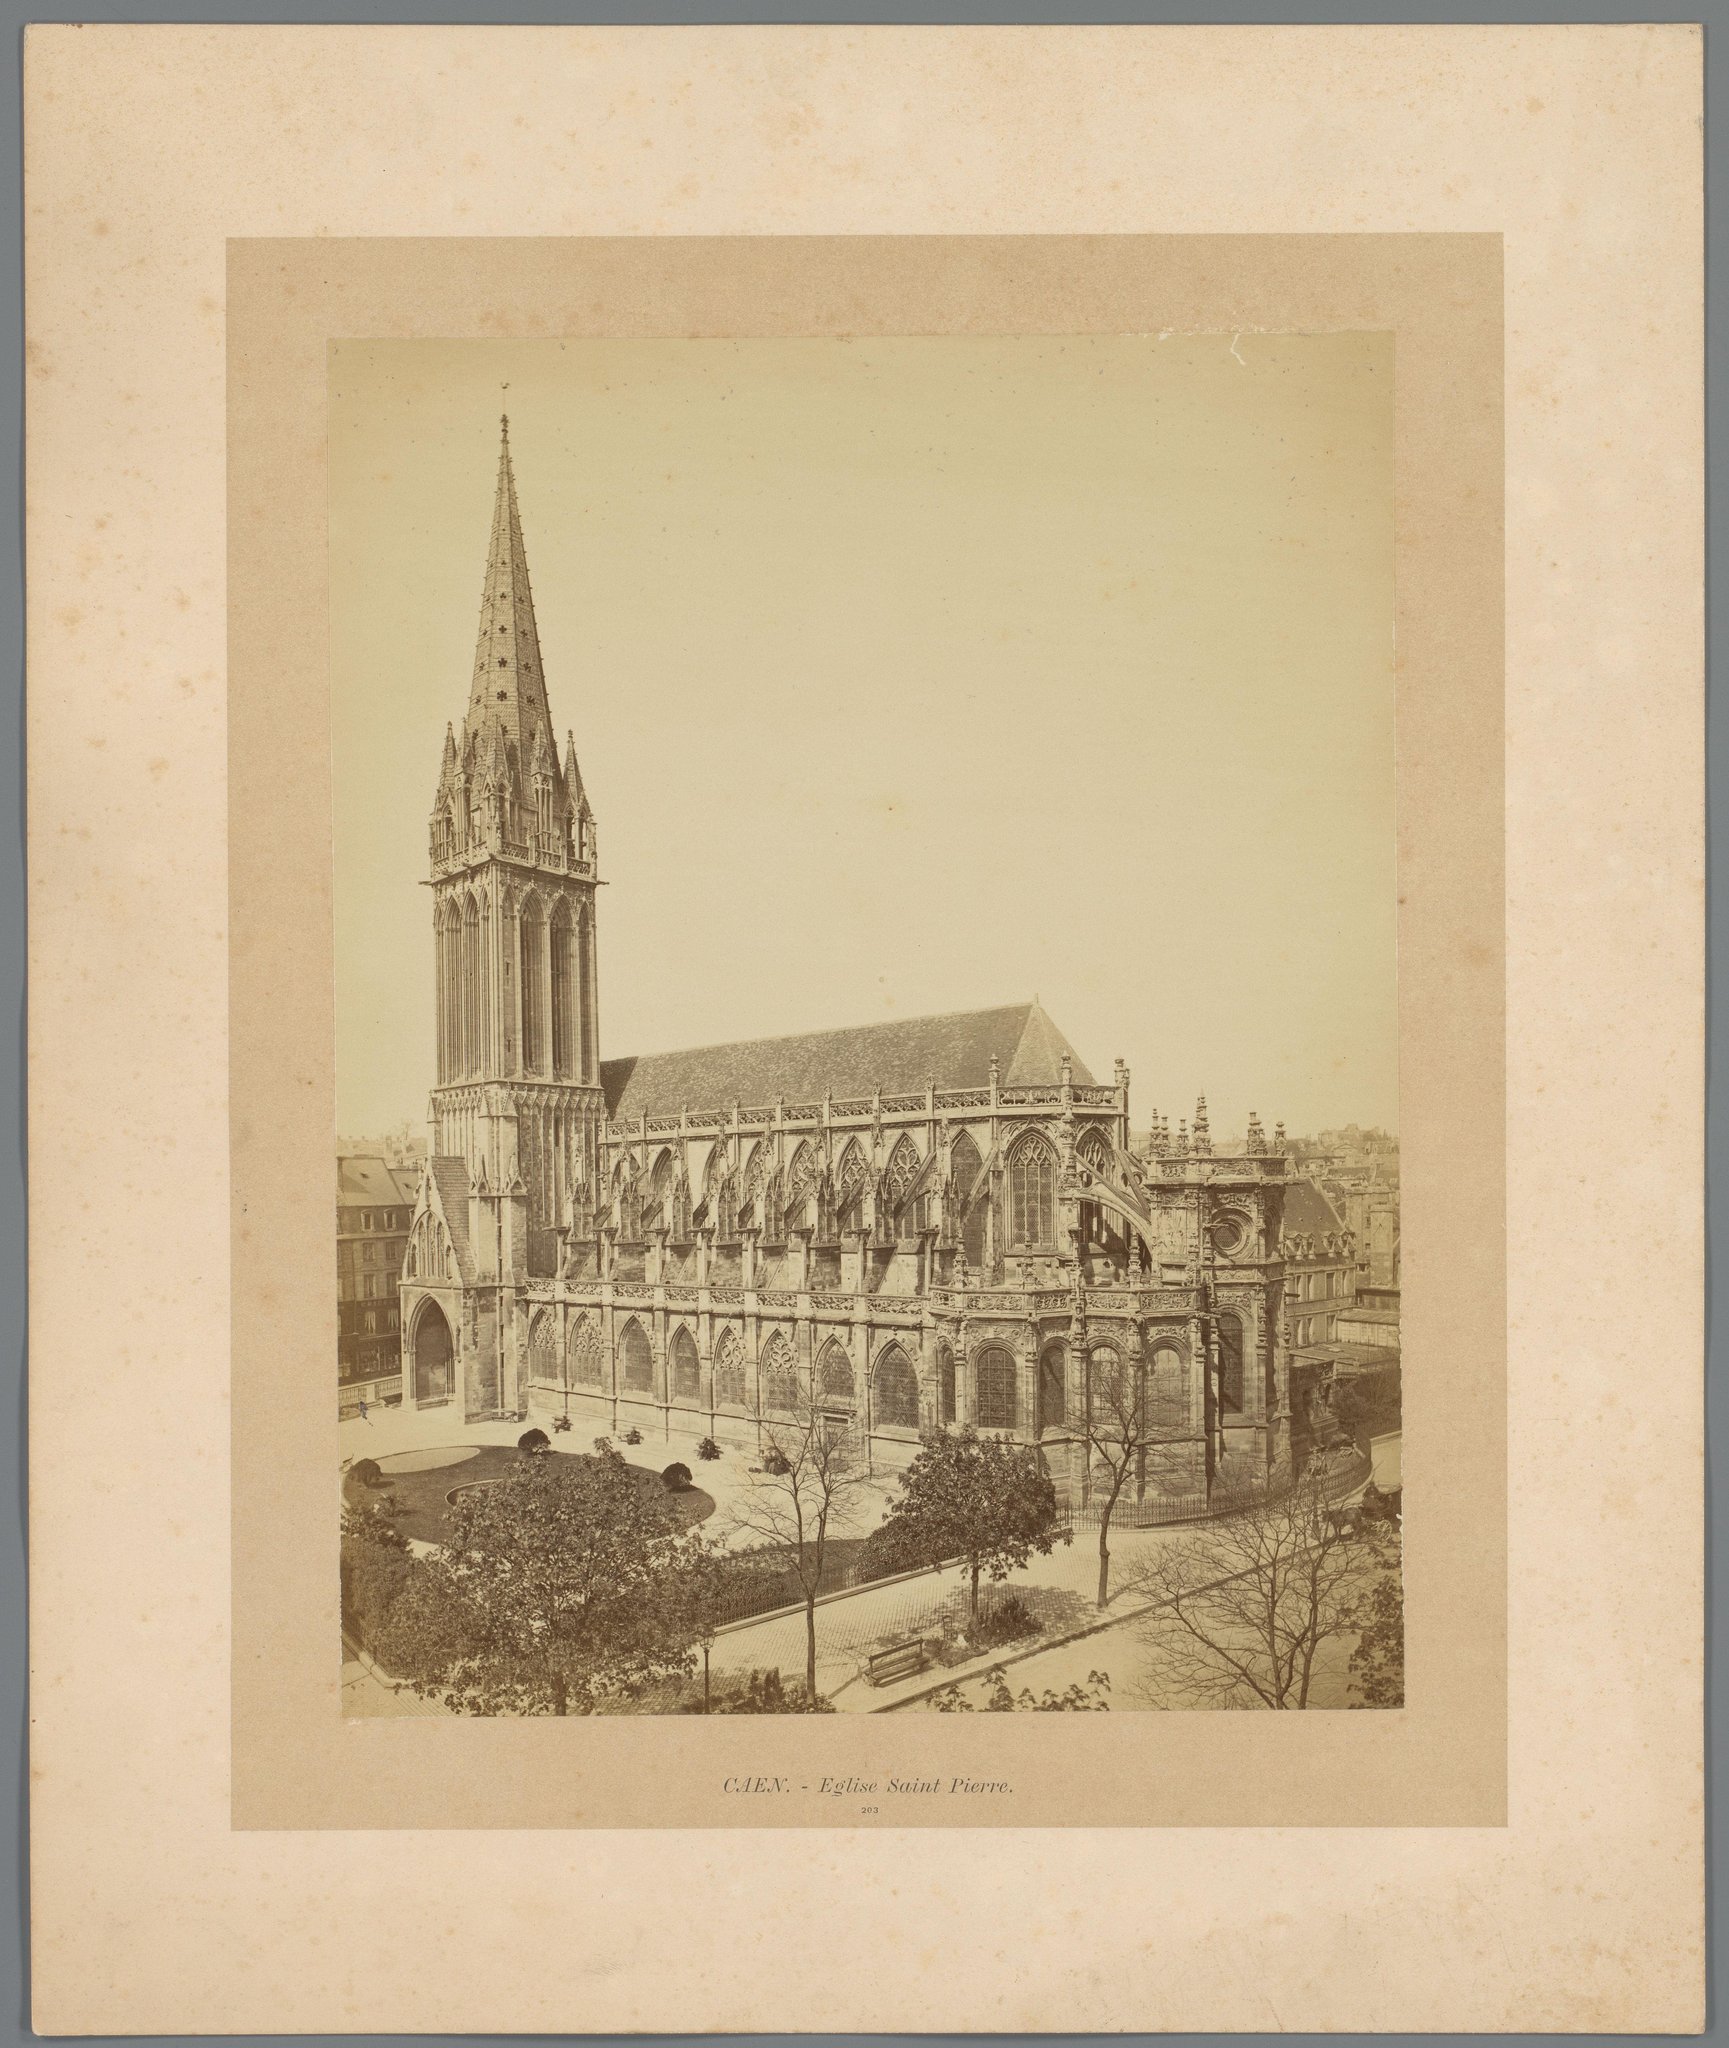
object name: photograph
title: Gezicht op de Sint-Petruskerk, Caen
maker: Anonymous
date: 1860-1890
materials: cardboard, paper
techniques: albumen print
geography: caen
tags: church (exterior)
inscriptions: inscription: ‘uit K.O.G. 1980’, number: ‘203’